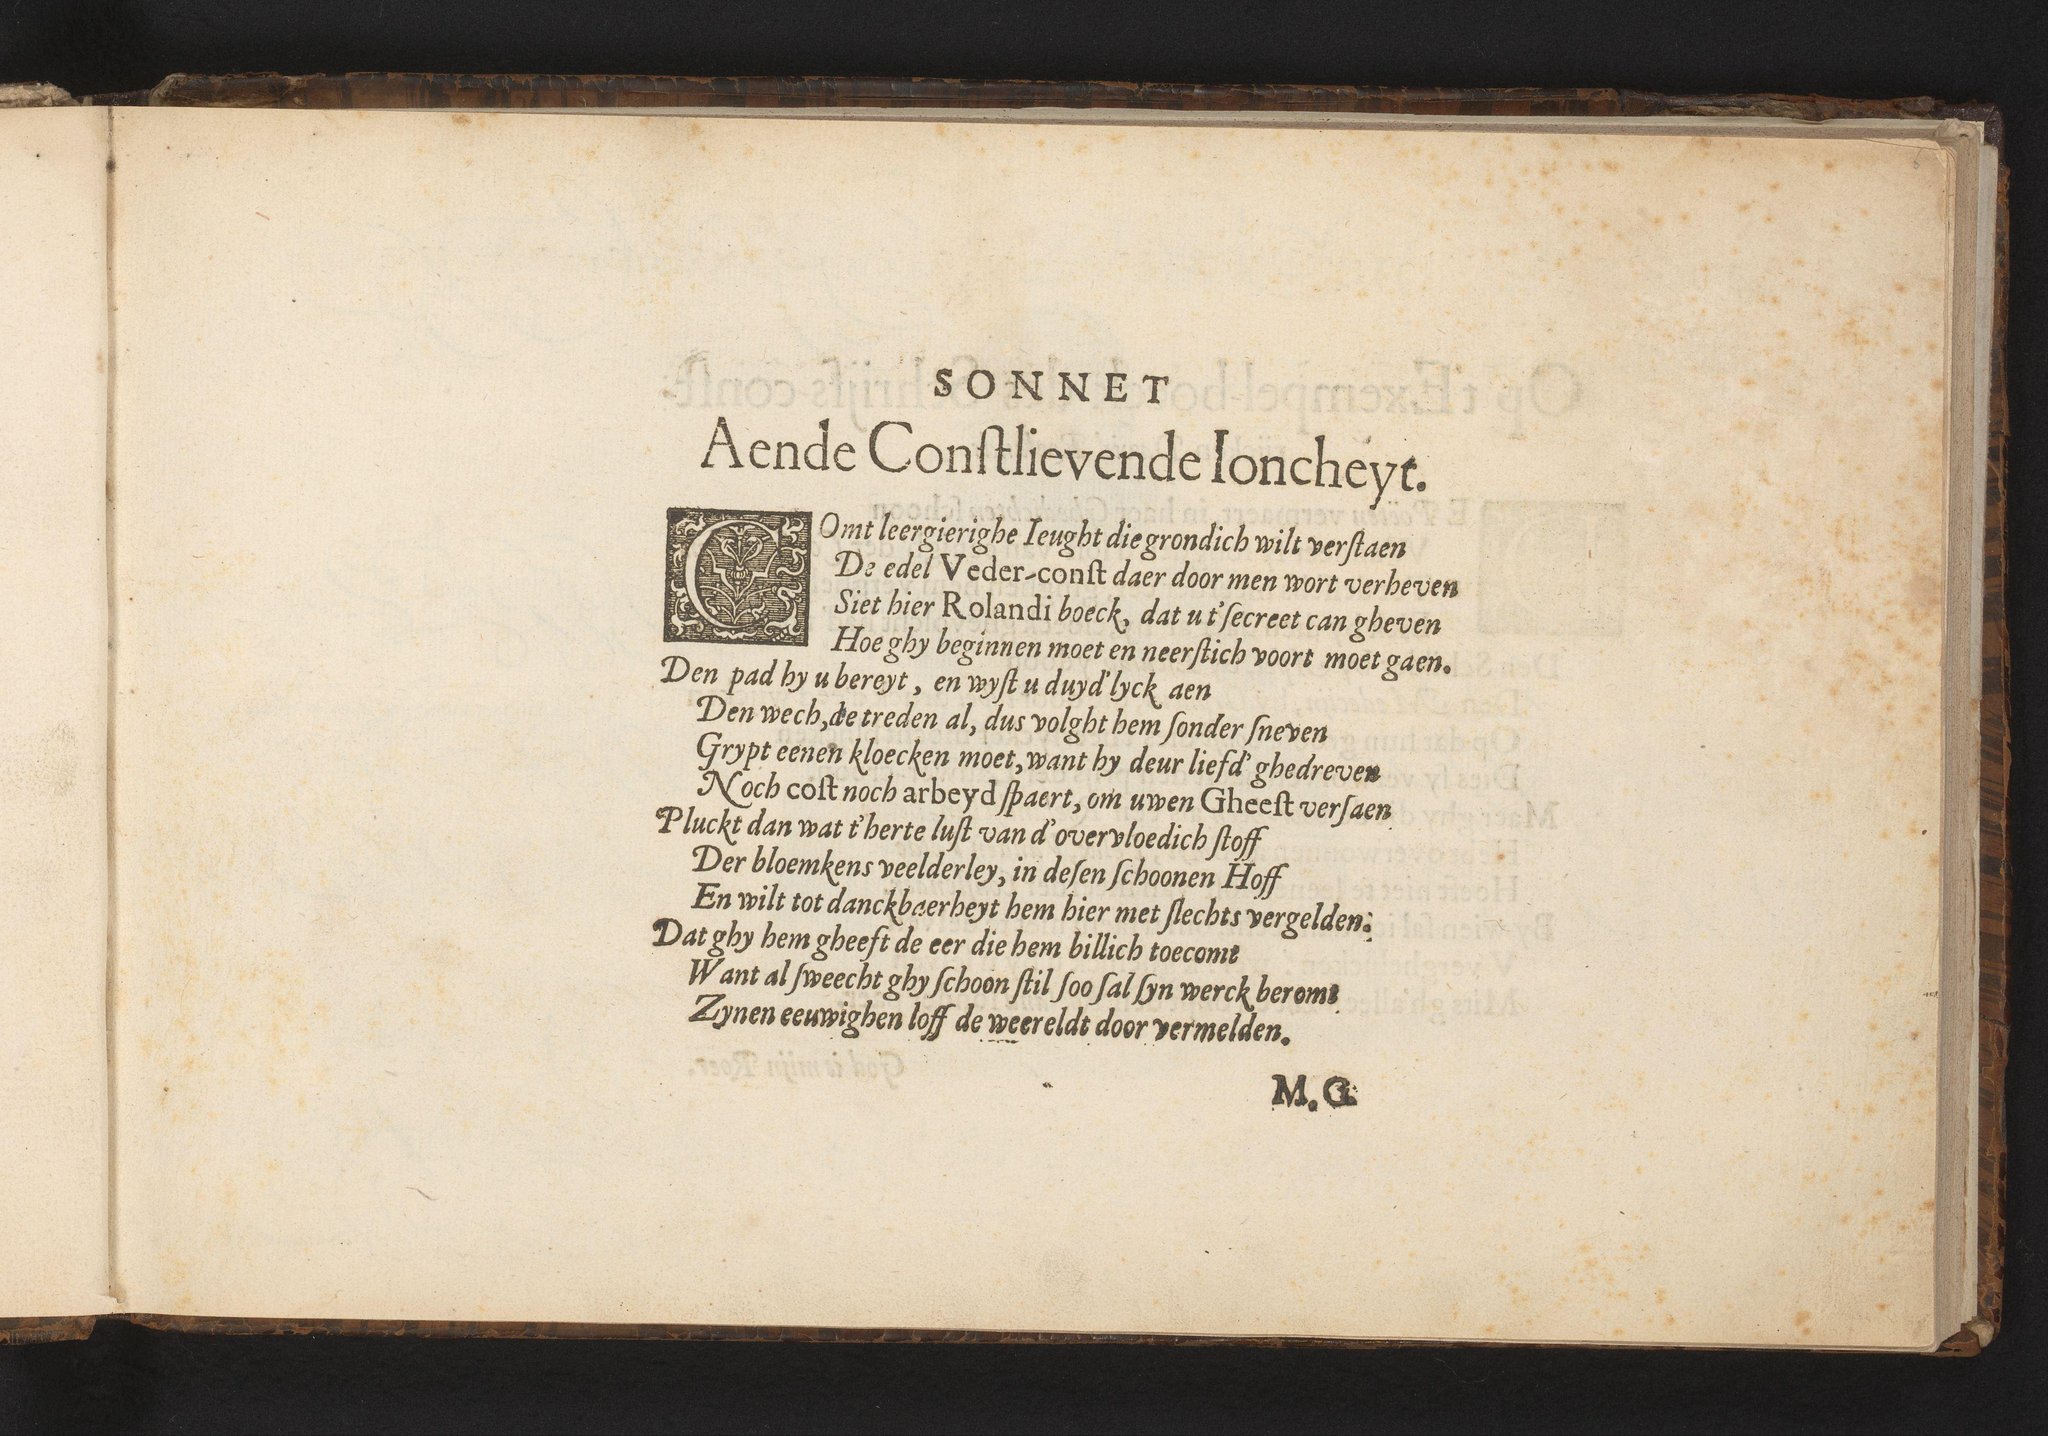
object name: text sheet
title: Nederlandstalig sonnet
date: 1616-1617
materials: paper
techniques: letterpress printing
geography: flushing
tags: initial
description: Tekstblad met een sonnet als drempeldicht in 't Magazin oft pac-huys. De tekst vangt aan met een gedecoreerde initiaal C. Het tekstblad maakt deel uit van een album.